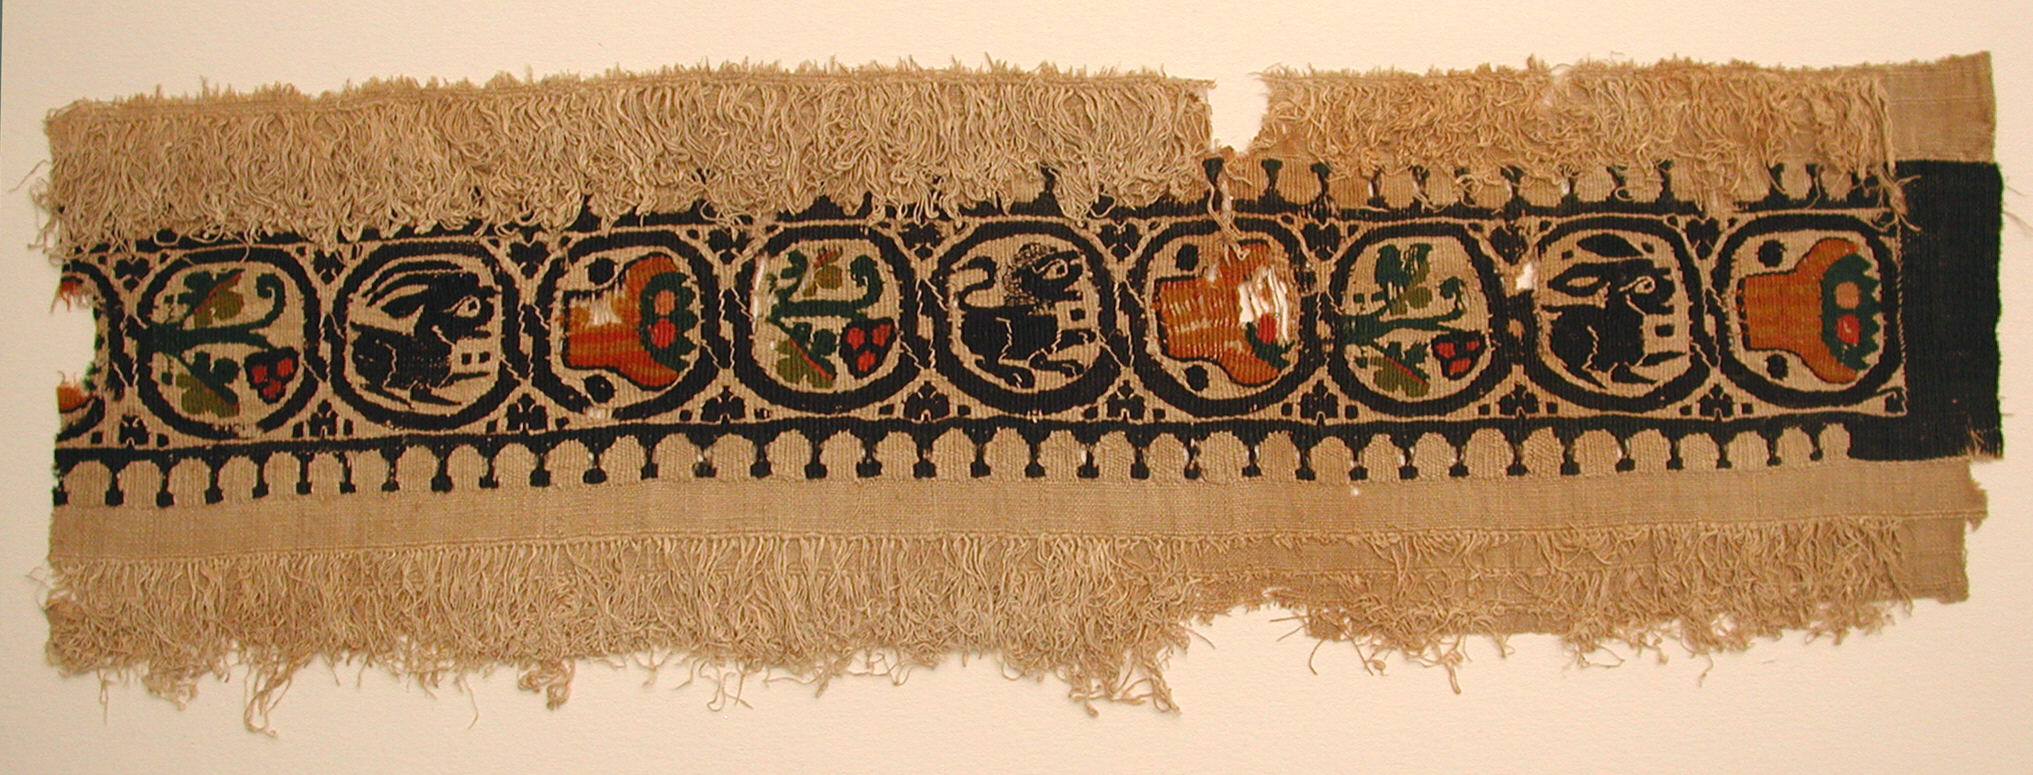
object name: textile fragment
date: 301-500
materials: linen, wool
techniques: weave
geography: egypt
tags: animals,flowers